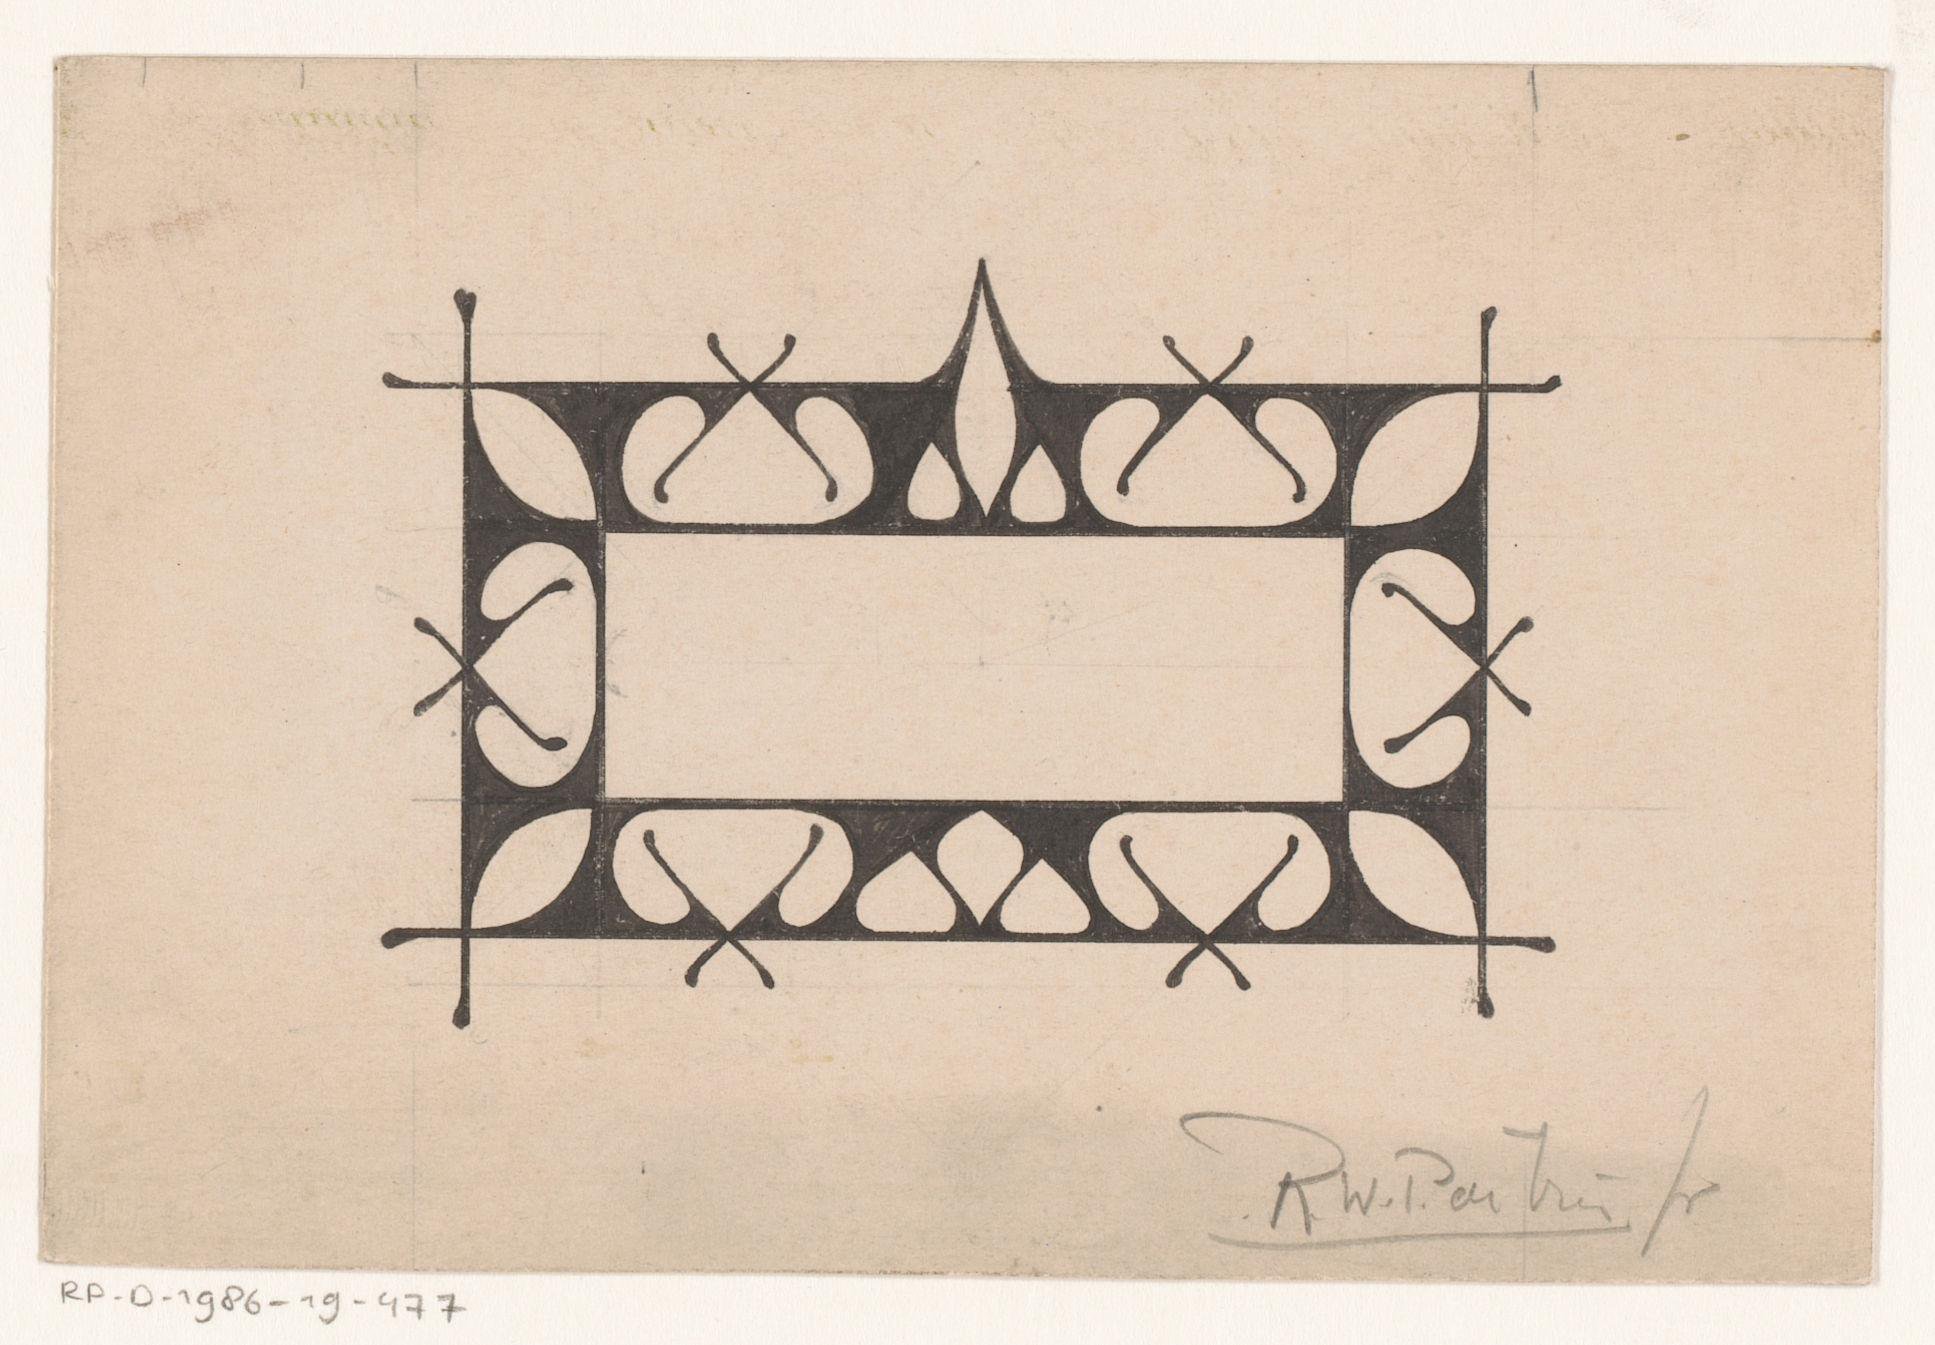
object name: drawing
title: Kader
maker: reinier willem petrus de vries (1874-1953)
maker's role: draughtsman, print maker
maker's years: 1874-1953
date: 1884-1952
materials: ink, paper, pencil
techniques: brush, pen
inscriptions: collector's mark: ‘R:MVS.’